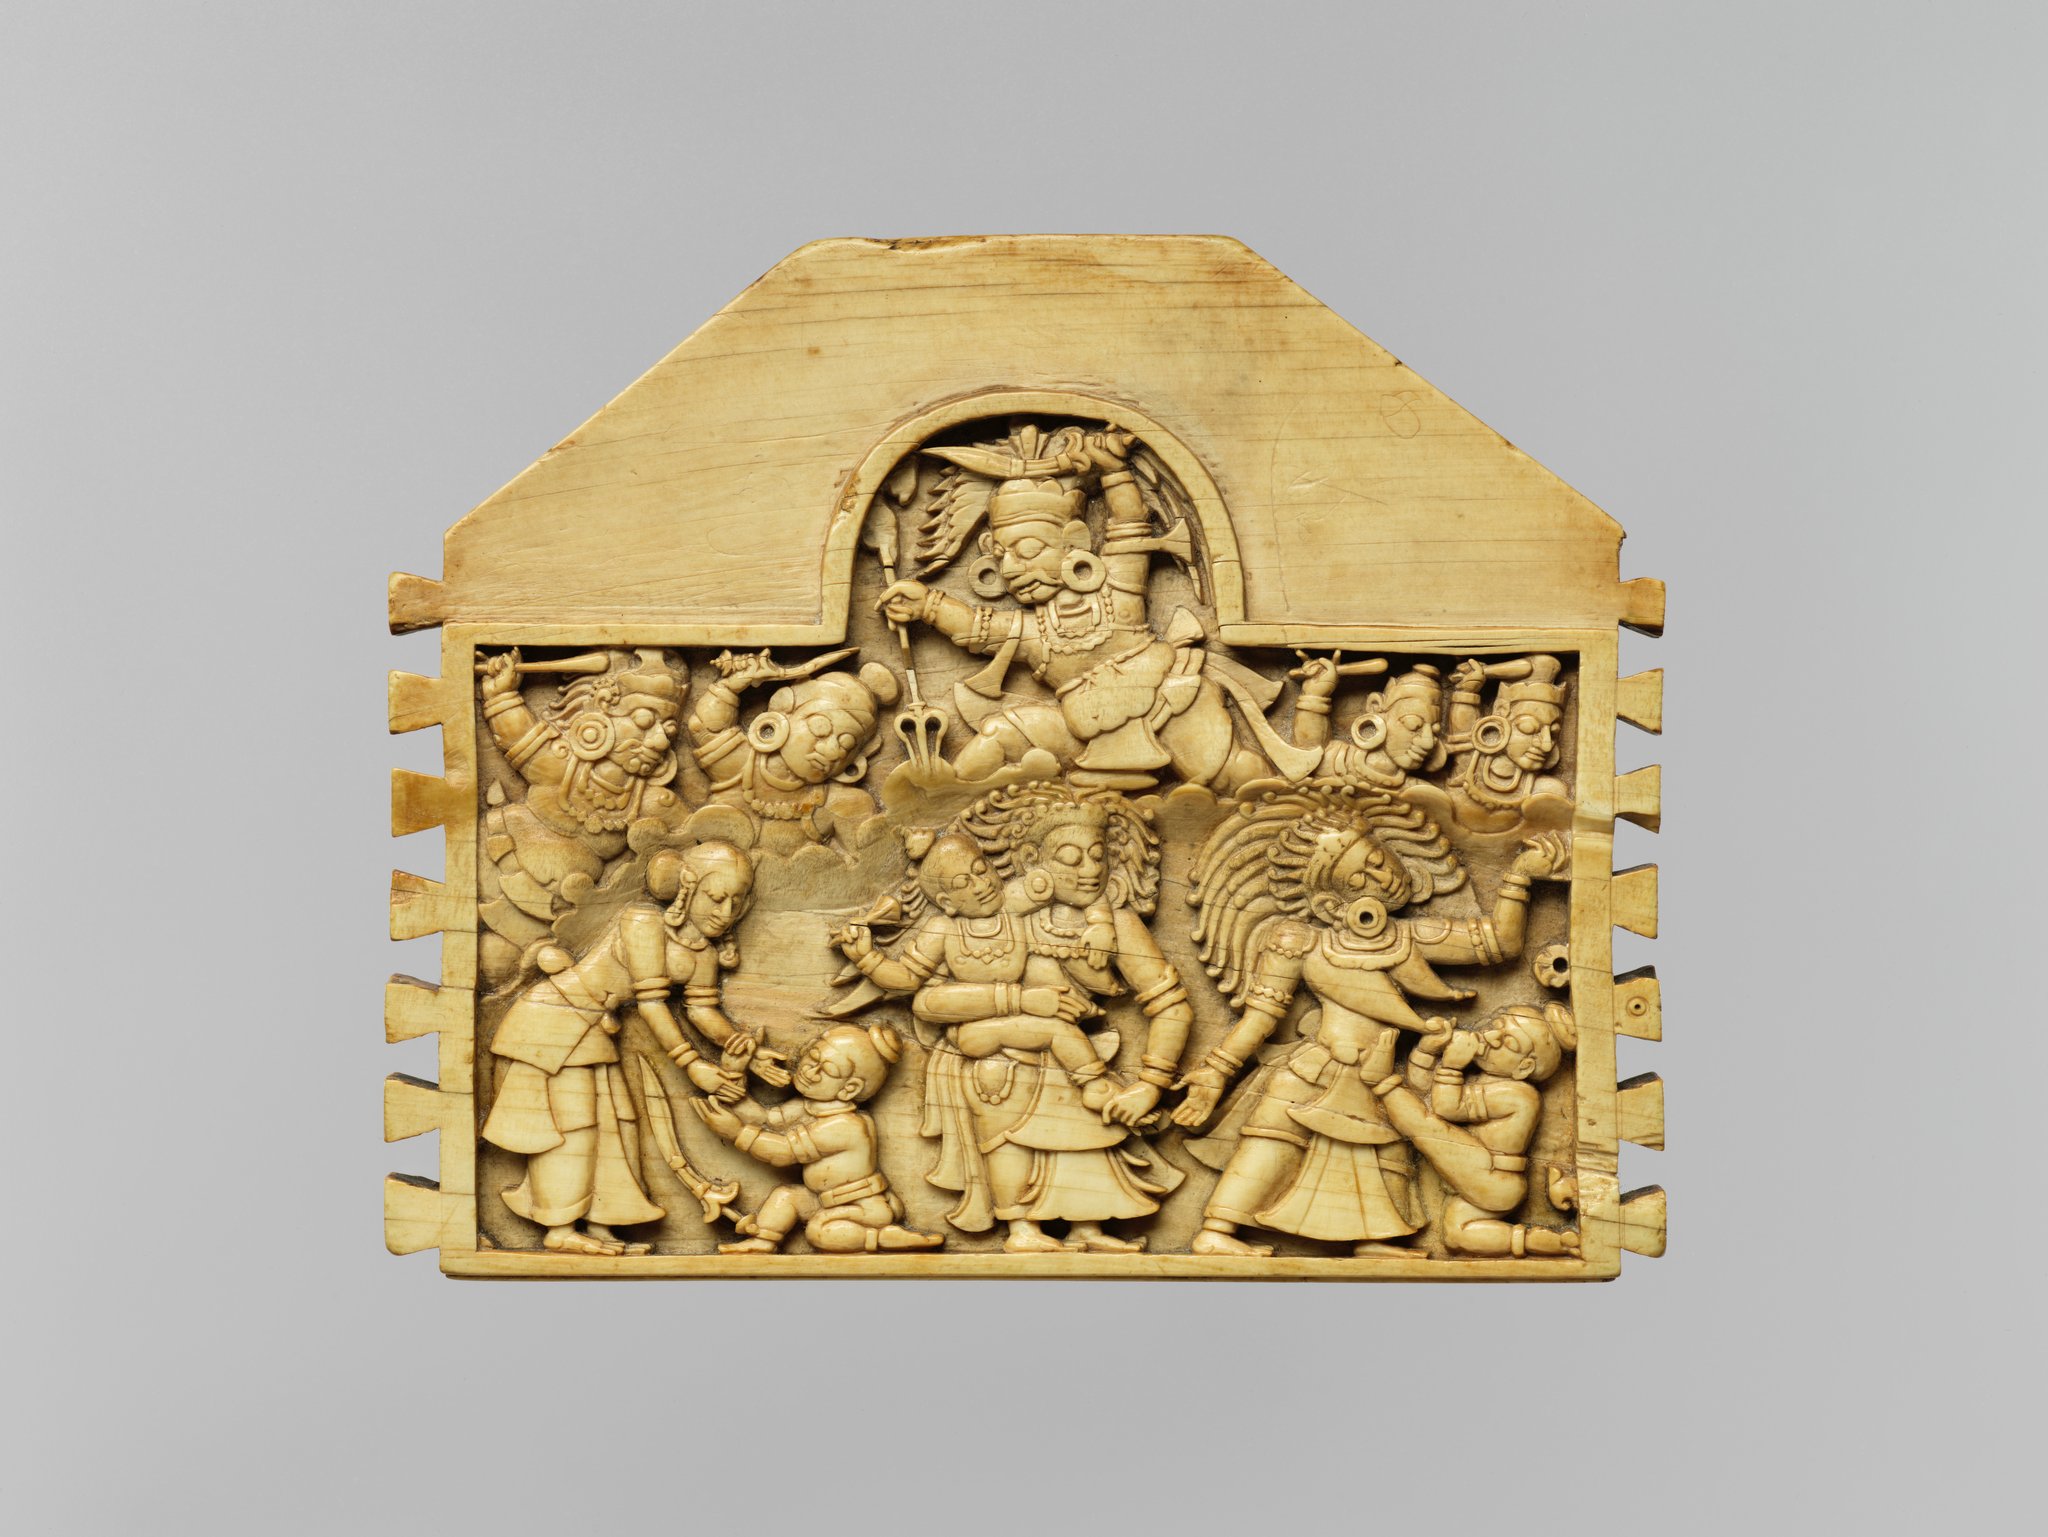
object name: panel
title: Panel from a jewelry casket: Krishna slays Putana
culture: south indian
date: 1534-1566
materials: ivory